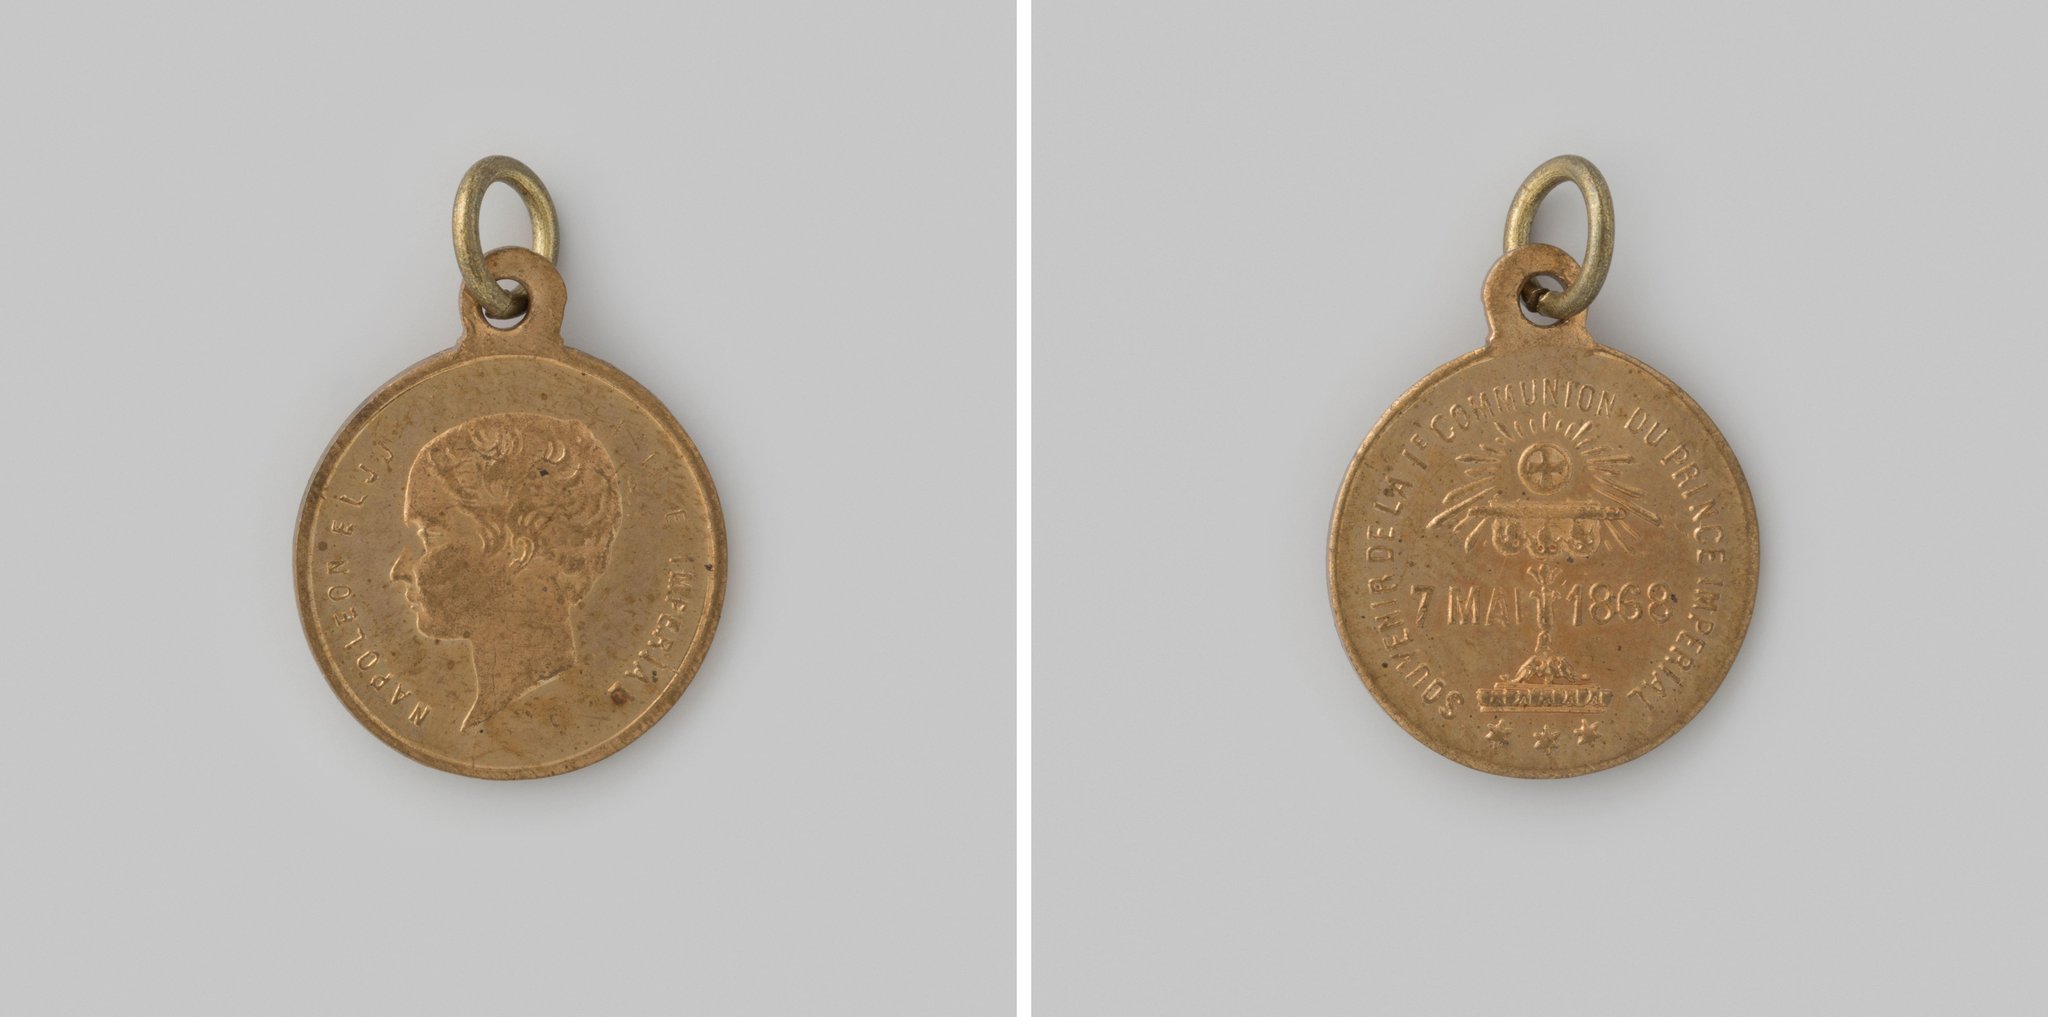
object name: history medal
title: Eerste communie van Keizerlijke Kroonprins Napoleon van Frankrijk 1868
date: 1868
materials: brass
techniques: striking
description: Verguld penninkje met oog en draagring, op de voorzijde het portret van kroonprins Napoleon naar links met omschrift, op de keerzijde een kelk waarboven een stralend kruis, met één regel tekst en omschrift.